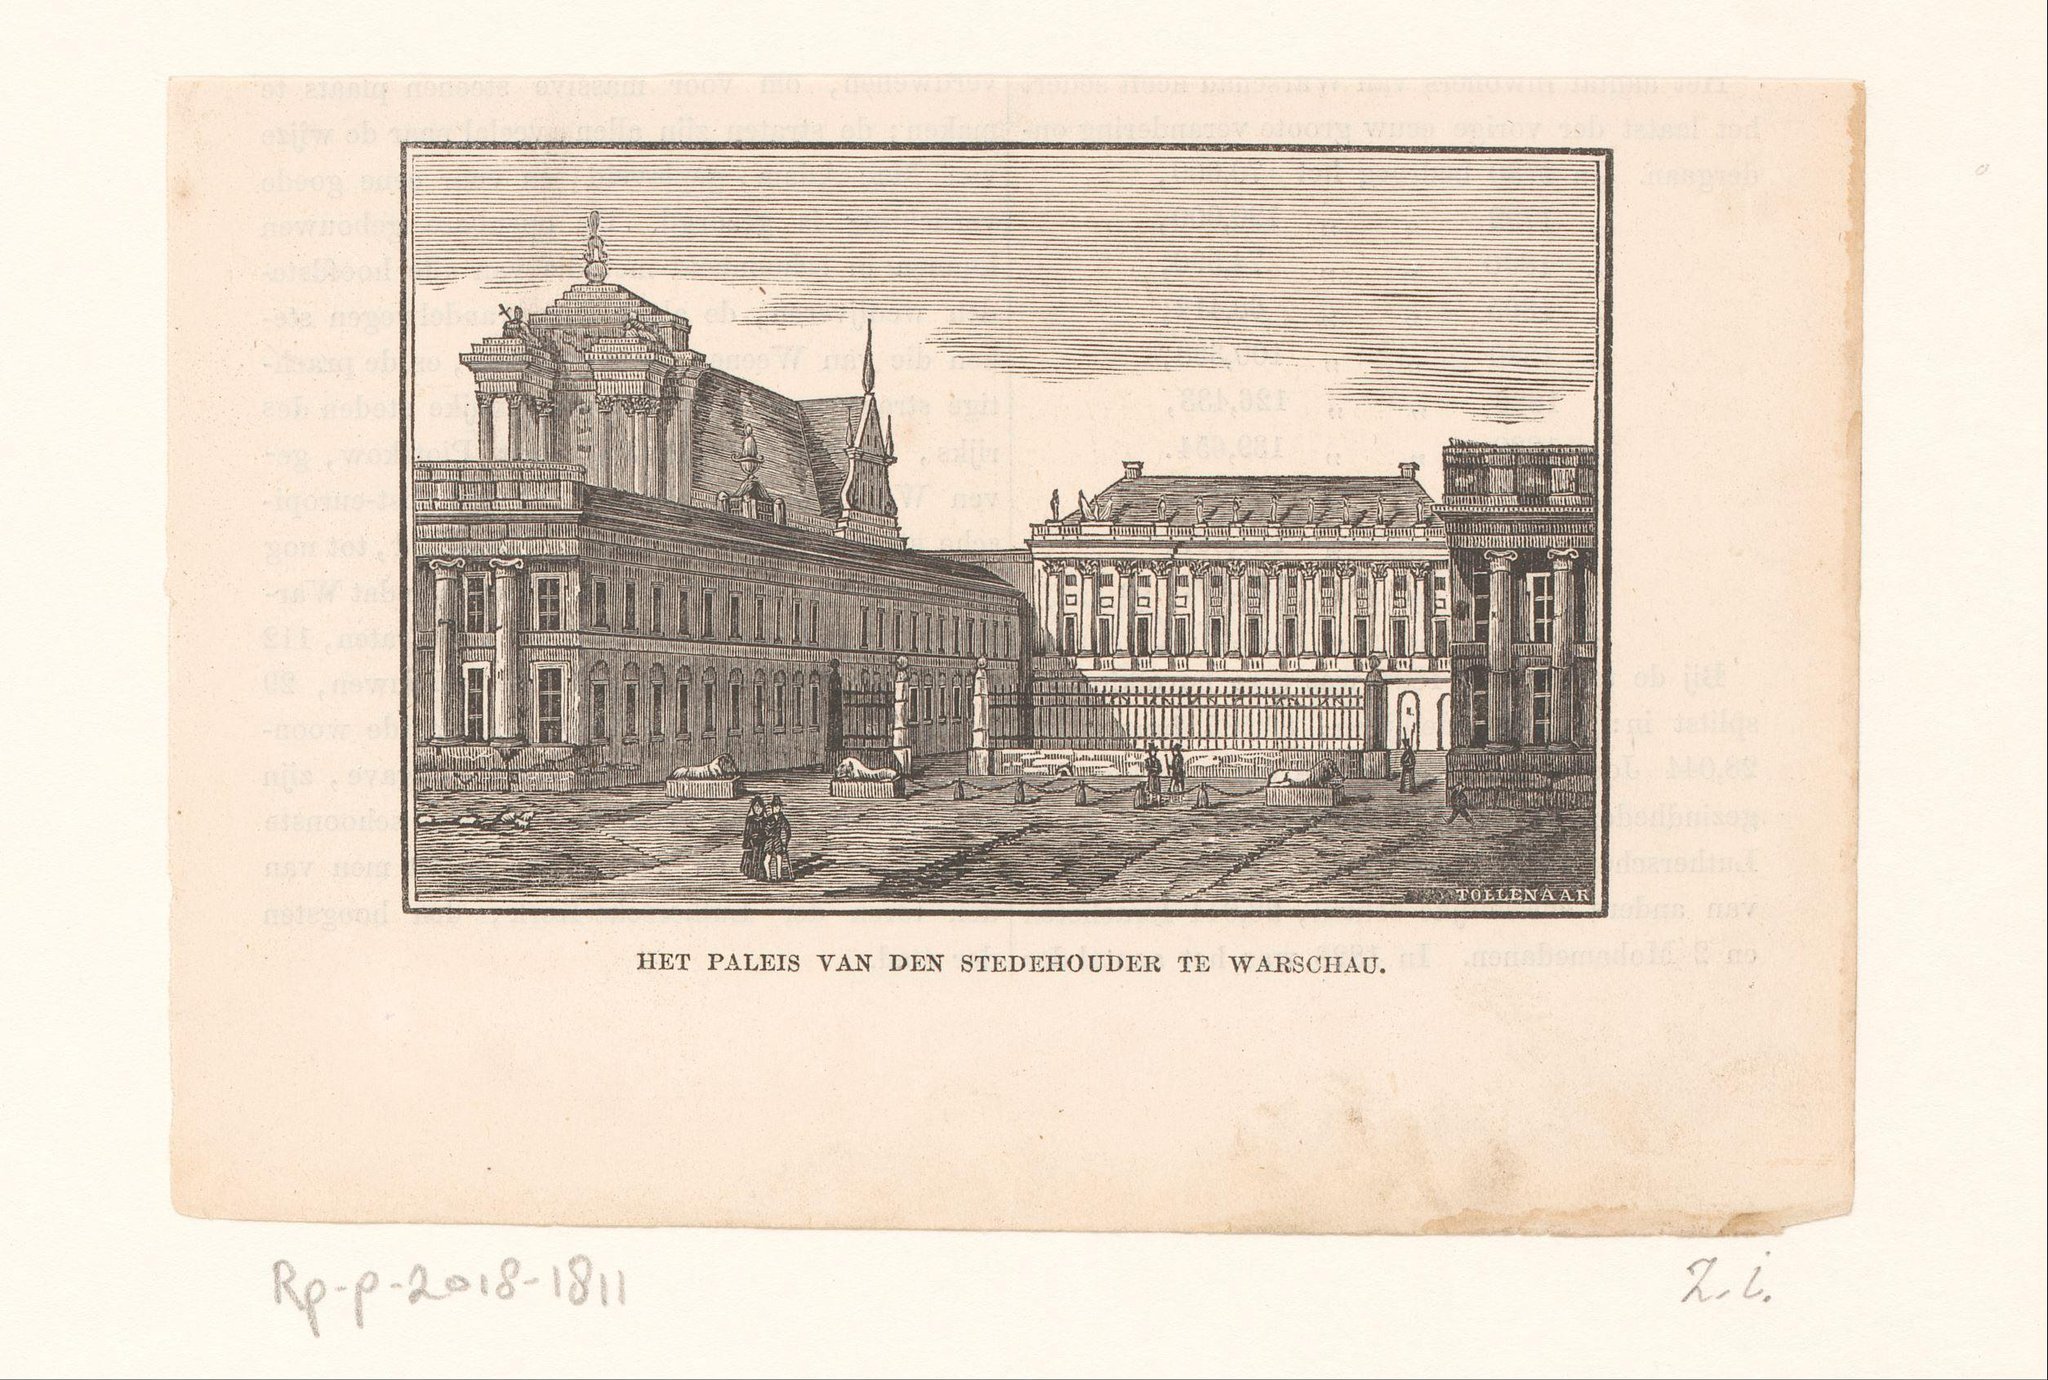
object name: print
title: Het paleis van den stedenhouder te Warschau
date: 1847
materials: paper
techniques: letterpress printing, engraving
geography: amsterdam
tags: palace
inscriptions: collector's mark: Lugt 2228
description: Prent gebruikt in: Witkamp, P.H. Beschrijving van Oost- en Noord-Europa. Amsterdam: J.H. Laarman, 1847.